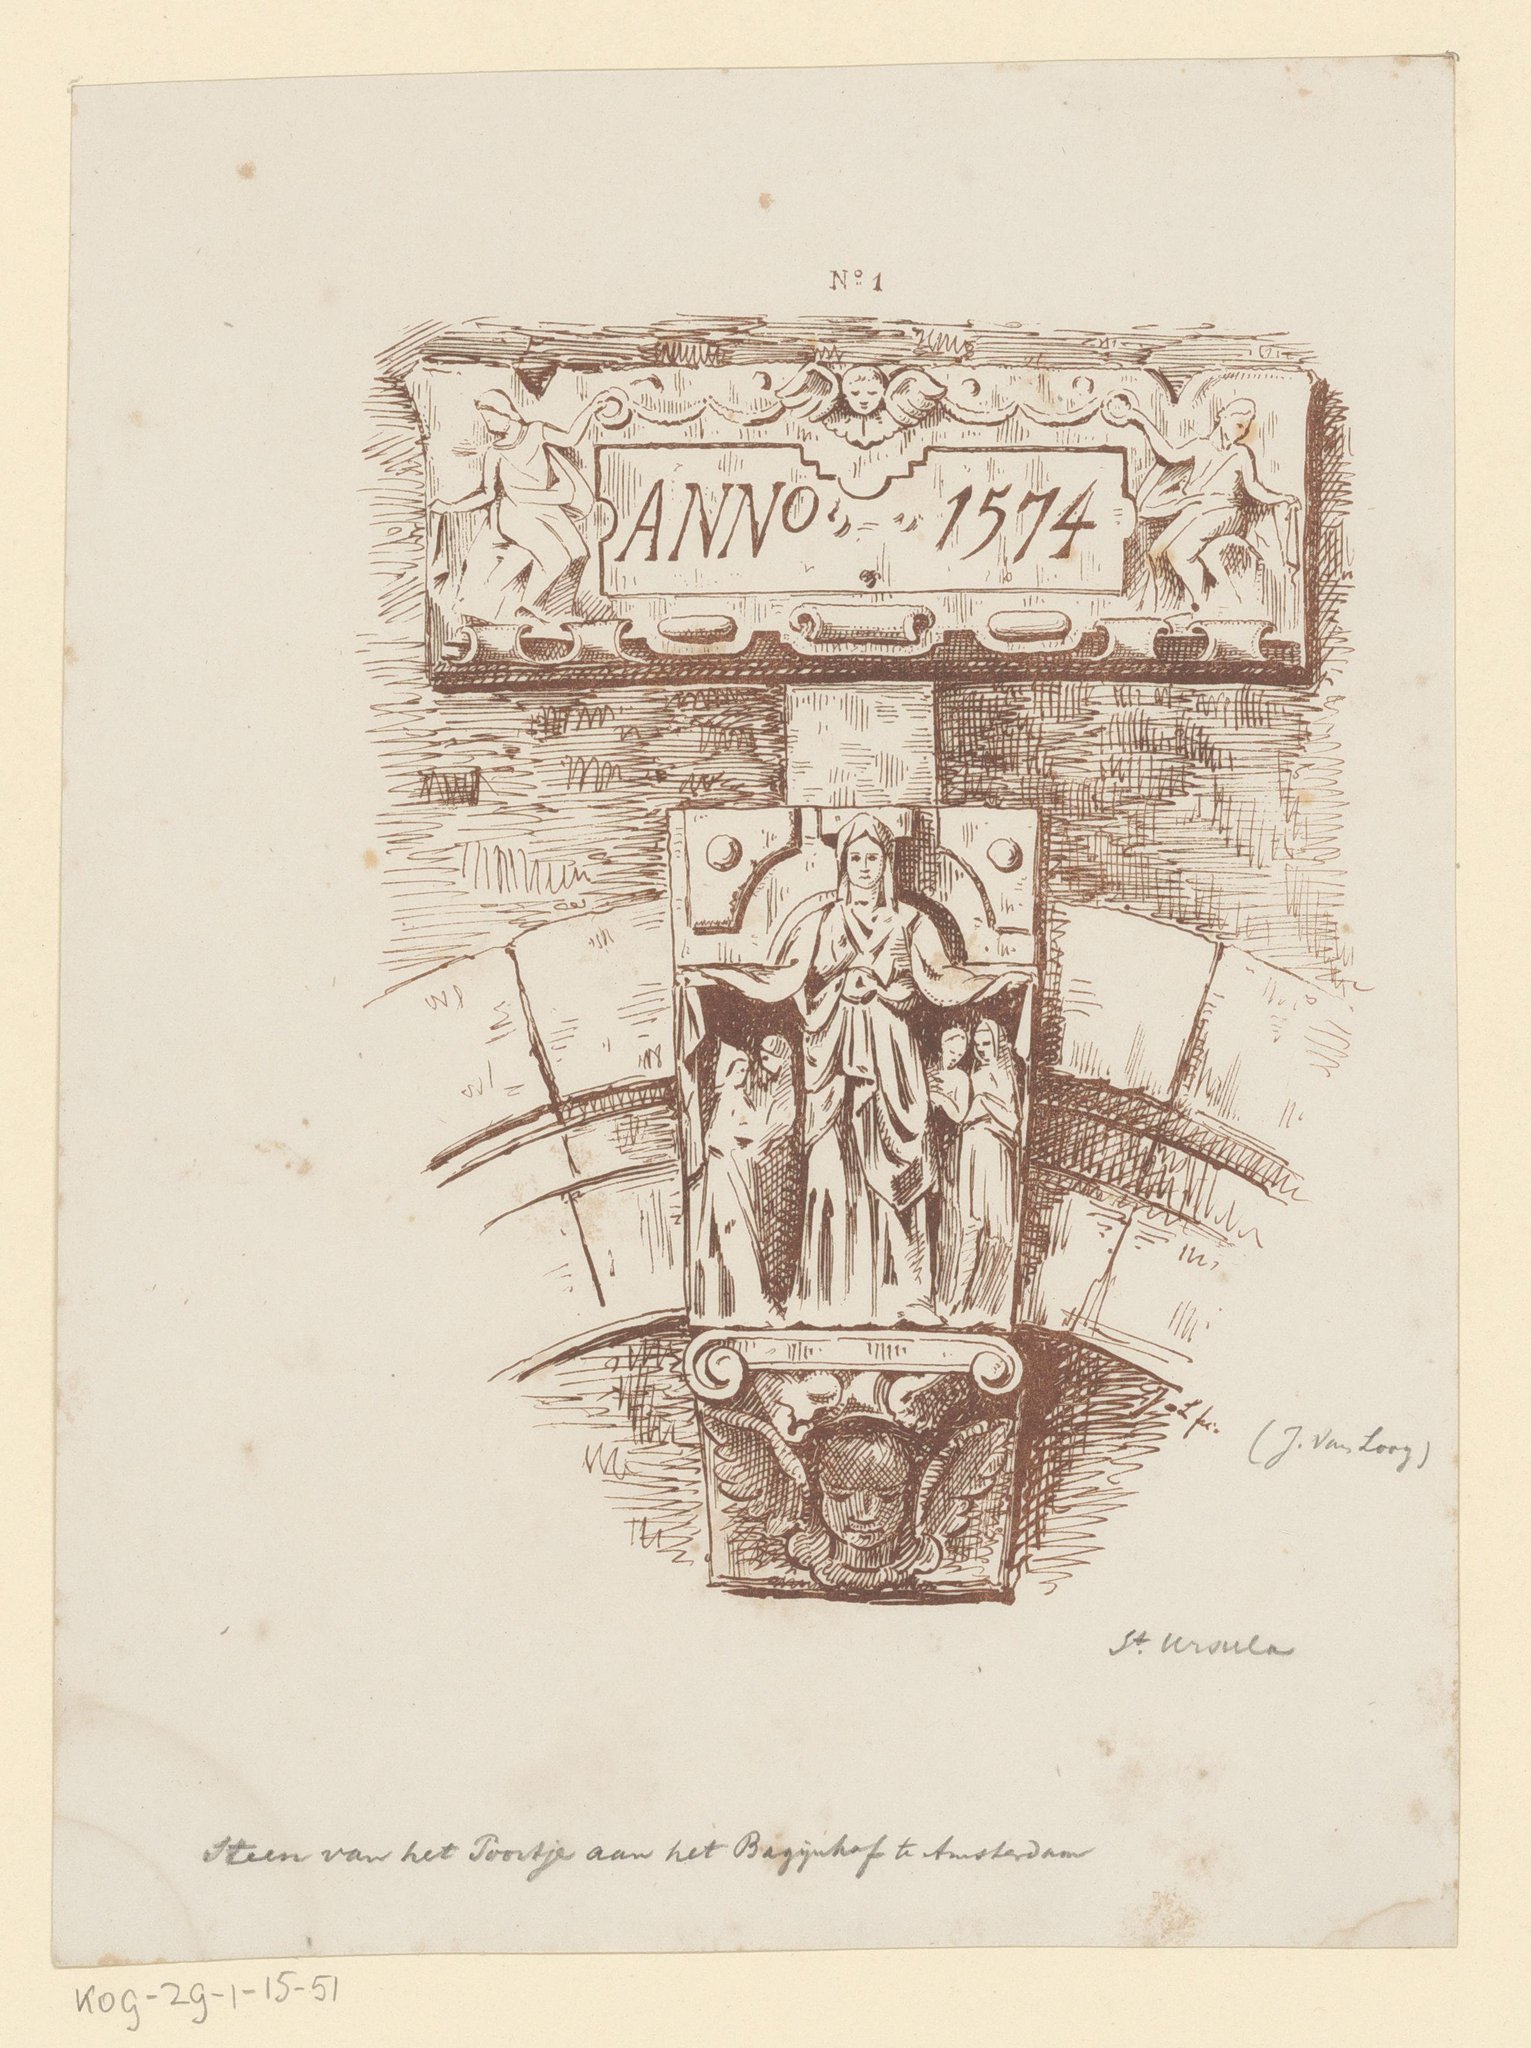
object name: print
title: Sluitsteen met heilige Ursula Begijnhof in Amsterdam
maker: jac van looij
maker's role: draughtsman, painter, print maker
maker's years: 1855-1930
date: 1877-1894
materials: paper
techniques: lithograph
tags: st. ursula protecting the eleven thousand virgins with her cloak, keystone ~ architecture, amsterdam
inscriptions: collector's mark: Lugt 1641, stamp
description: Sluitsteen in de toegangspoort tot het Begijnhof op de Gedempte Begijnensloot. Genummerd midden boven: No. 1. Onderwerpsrubrieken binnen de Atlas Zeden en Gewoonten: Handel, nijverheid en verkeer, Uithangteekens, gevelstenen.